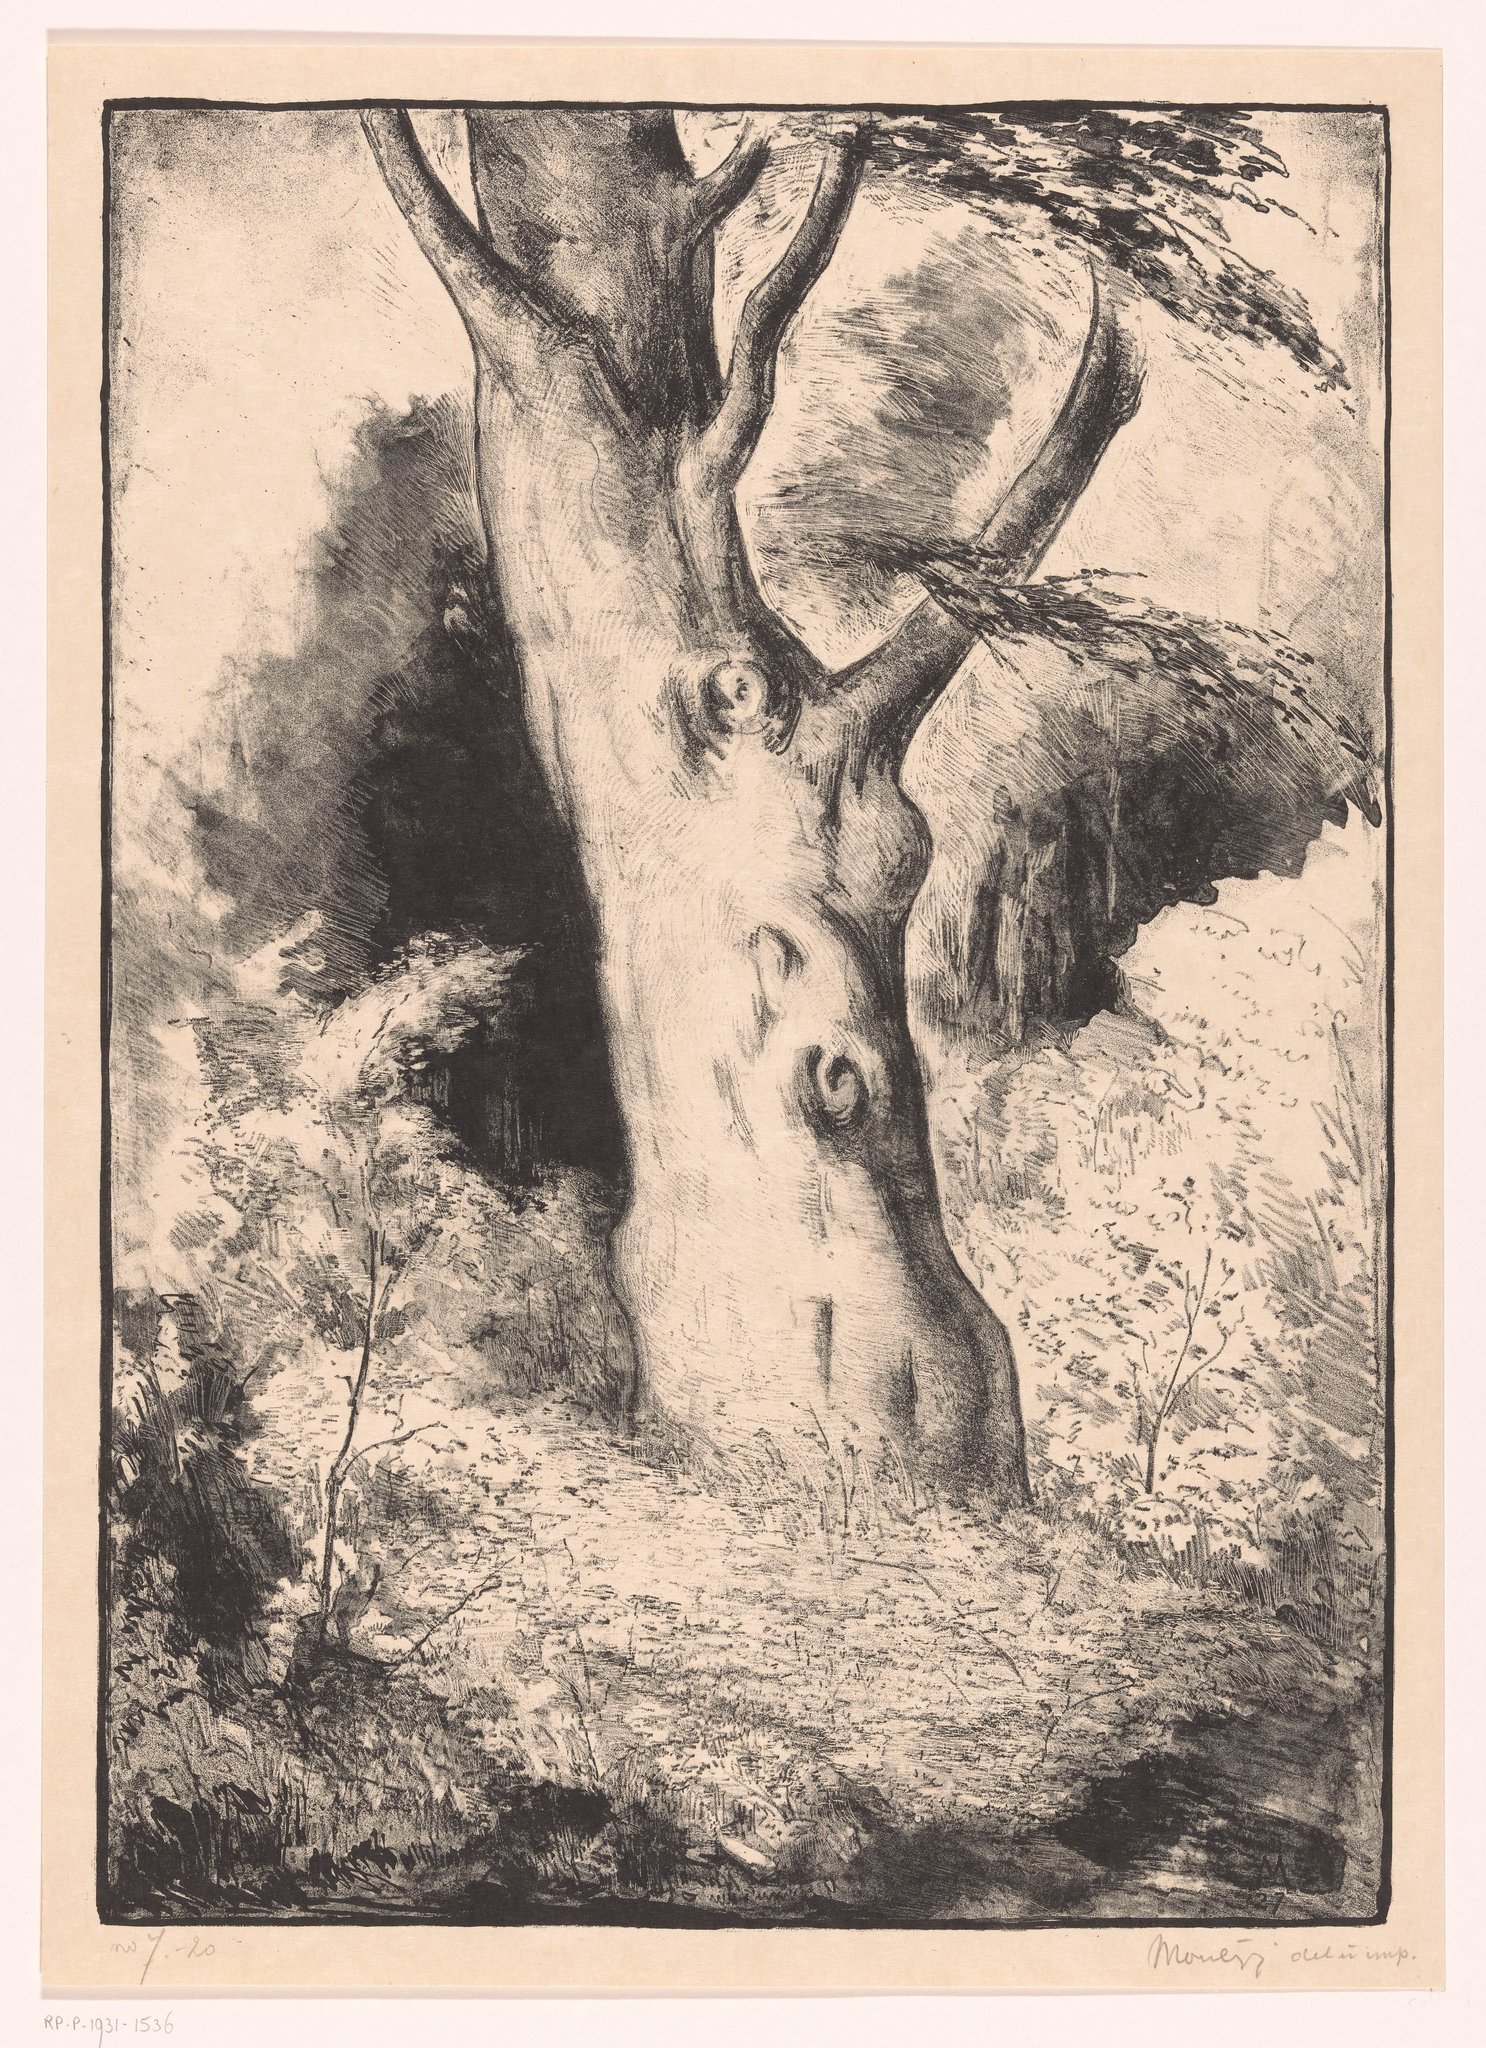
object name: print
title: Stam van een beukenboom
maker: simon moulijn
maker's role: draughtsman, print maker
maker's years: 1866-1948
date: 1927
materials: paper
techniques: lithograph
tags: trees: beech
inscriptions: collector's mark: Lugt 2228